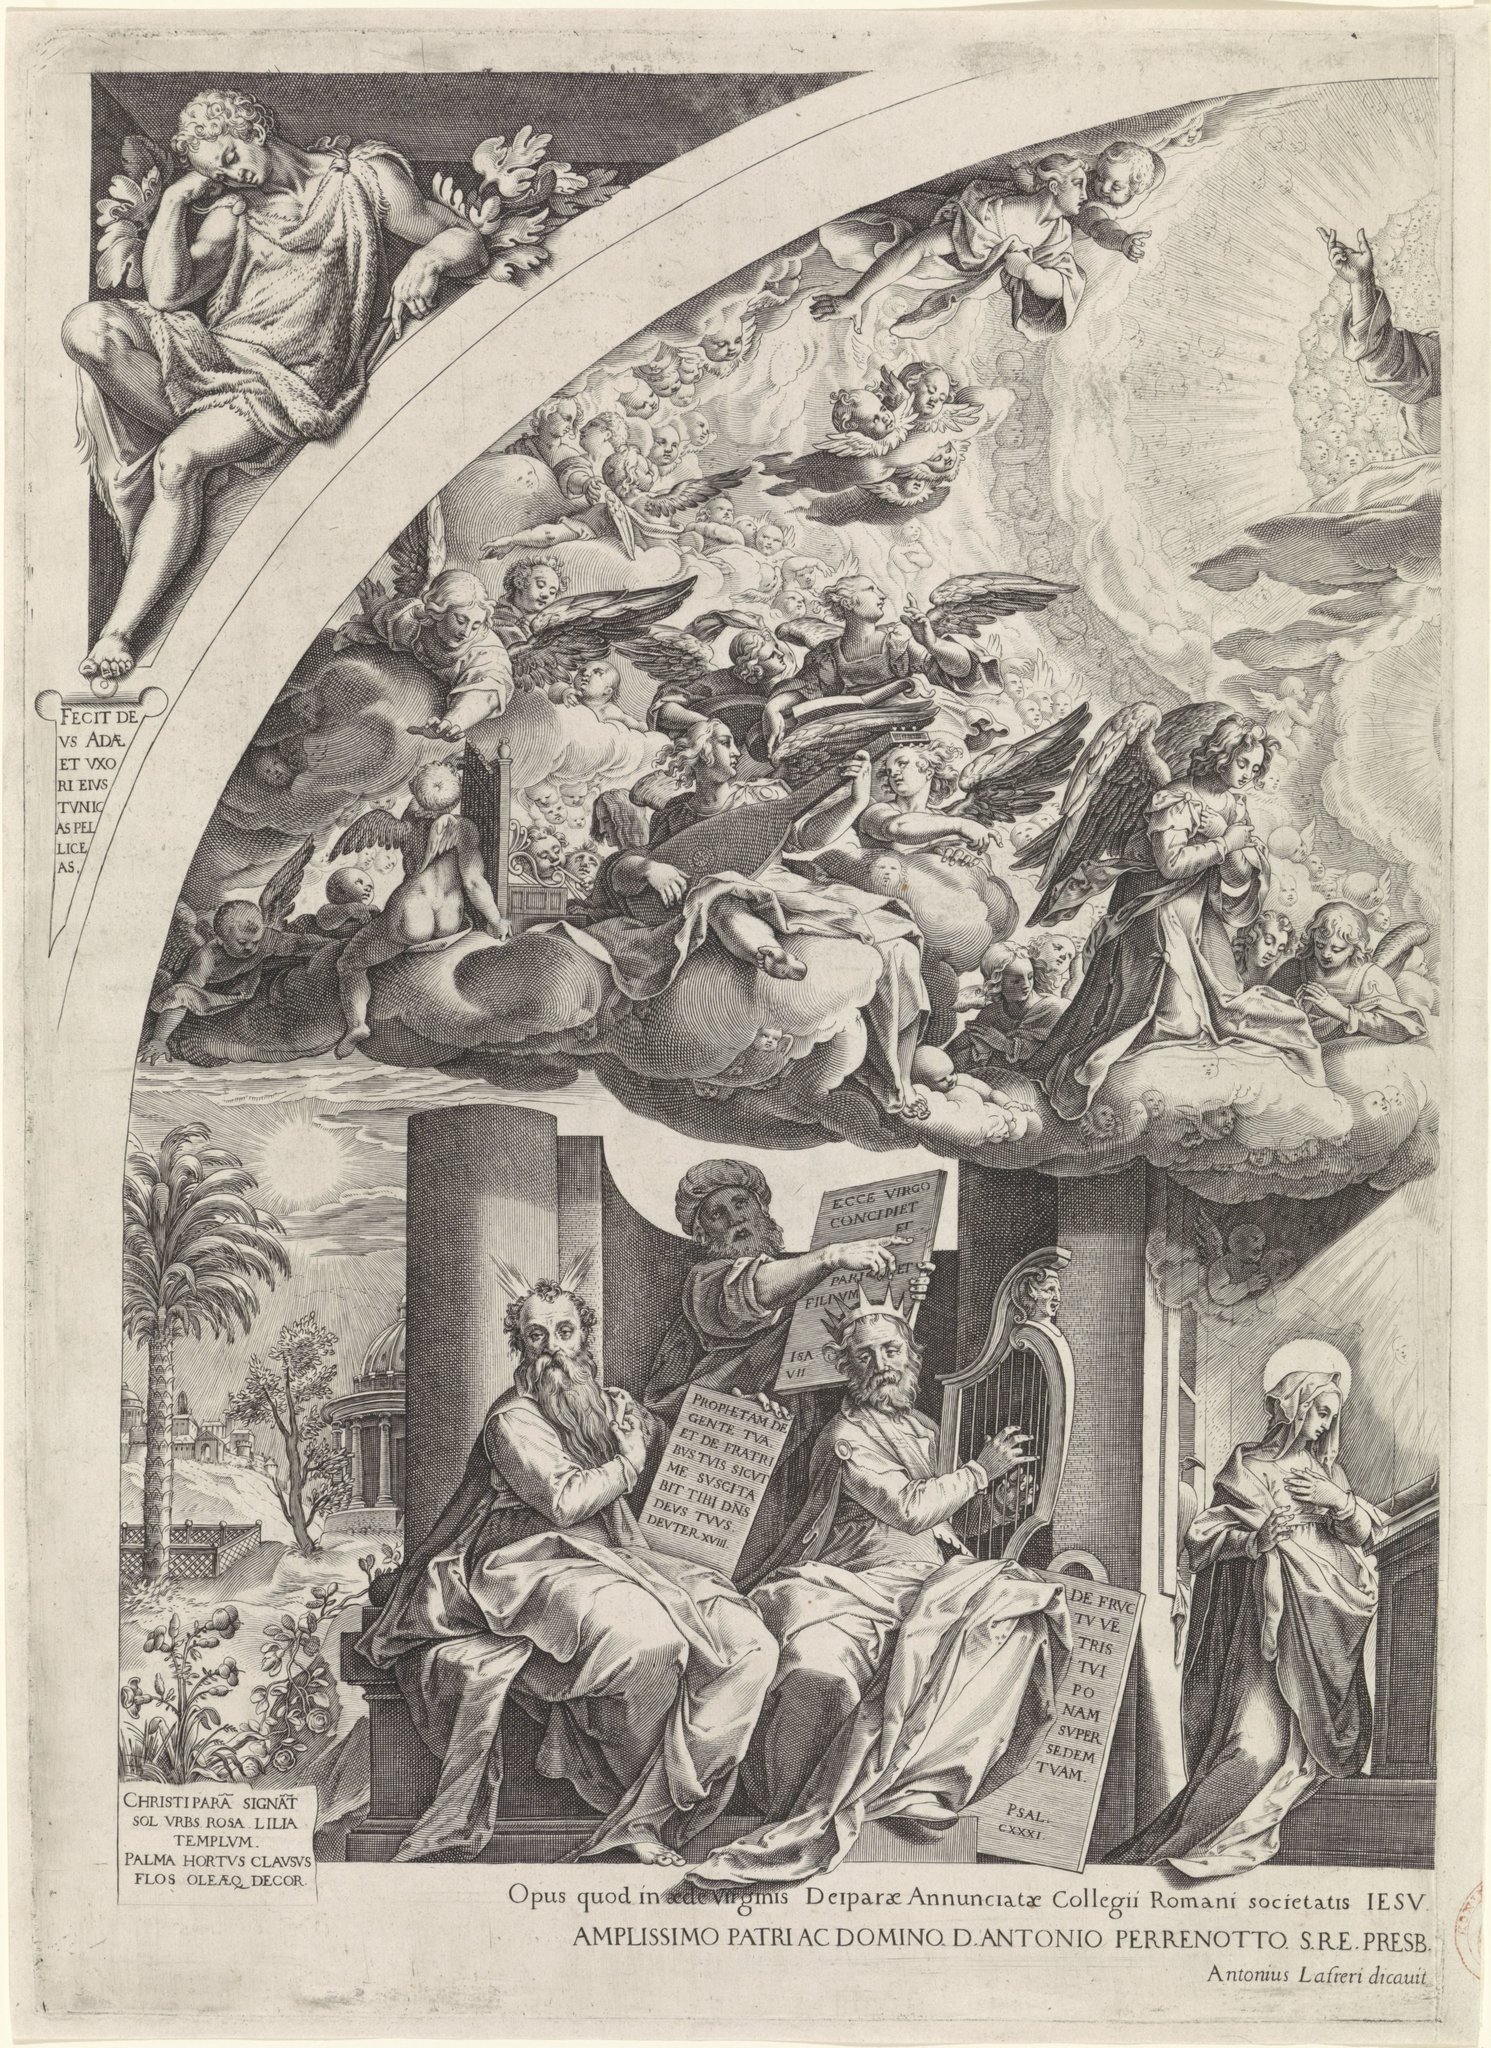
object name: print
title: Annunciatie, omgeven door profeten, linkerdeel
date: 1571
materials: paper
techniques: engraving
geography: rome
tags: the annunciation: mary kneeling, the twelve apostles ~ the twelve prophets, angels singing, making music, god the father represented as human being, usually with crown or tiara or sceptre and/or globe, holy ghost represented as a dove (in flames)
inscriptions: collector's mark: Lugt 240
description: In het midden de geknielde Maria, met voor haar de knielende engel met een lelie in de hand. Links en rechts profeten. Boven hen engelenkoren in de wolken, in het midden in een stralenkrans, God de Vader als oude man met wereldbol en de H. Geest in de gedaante van een duif.